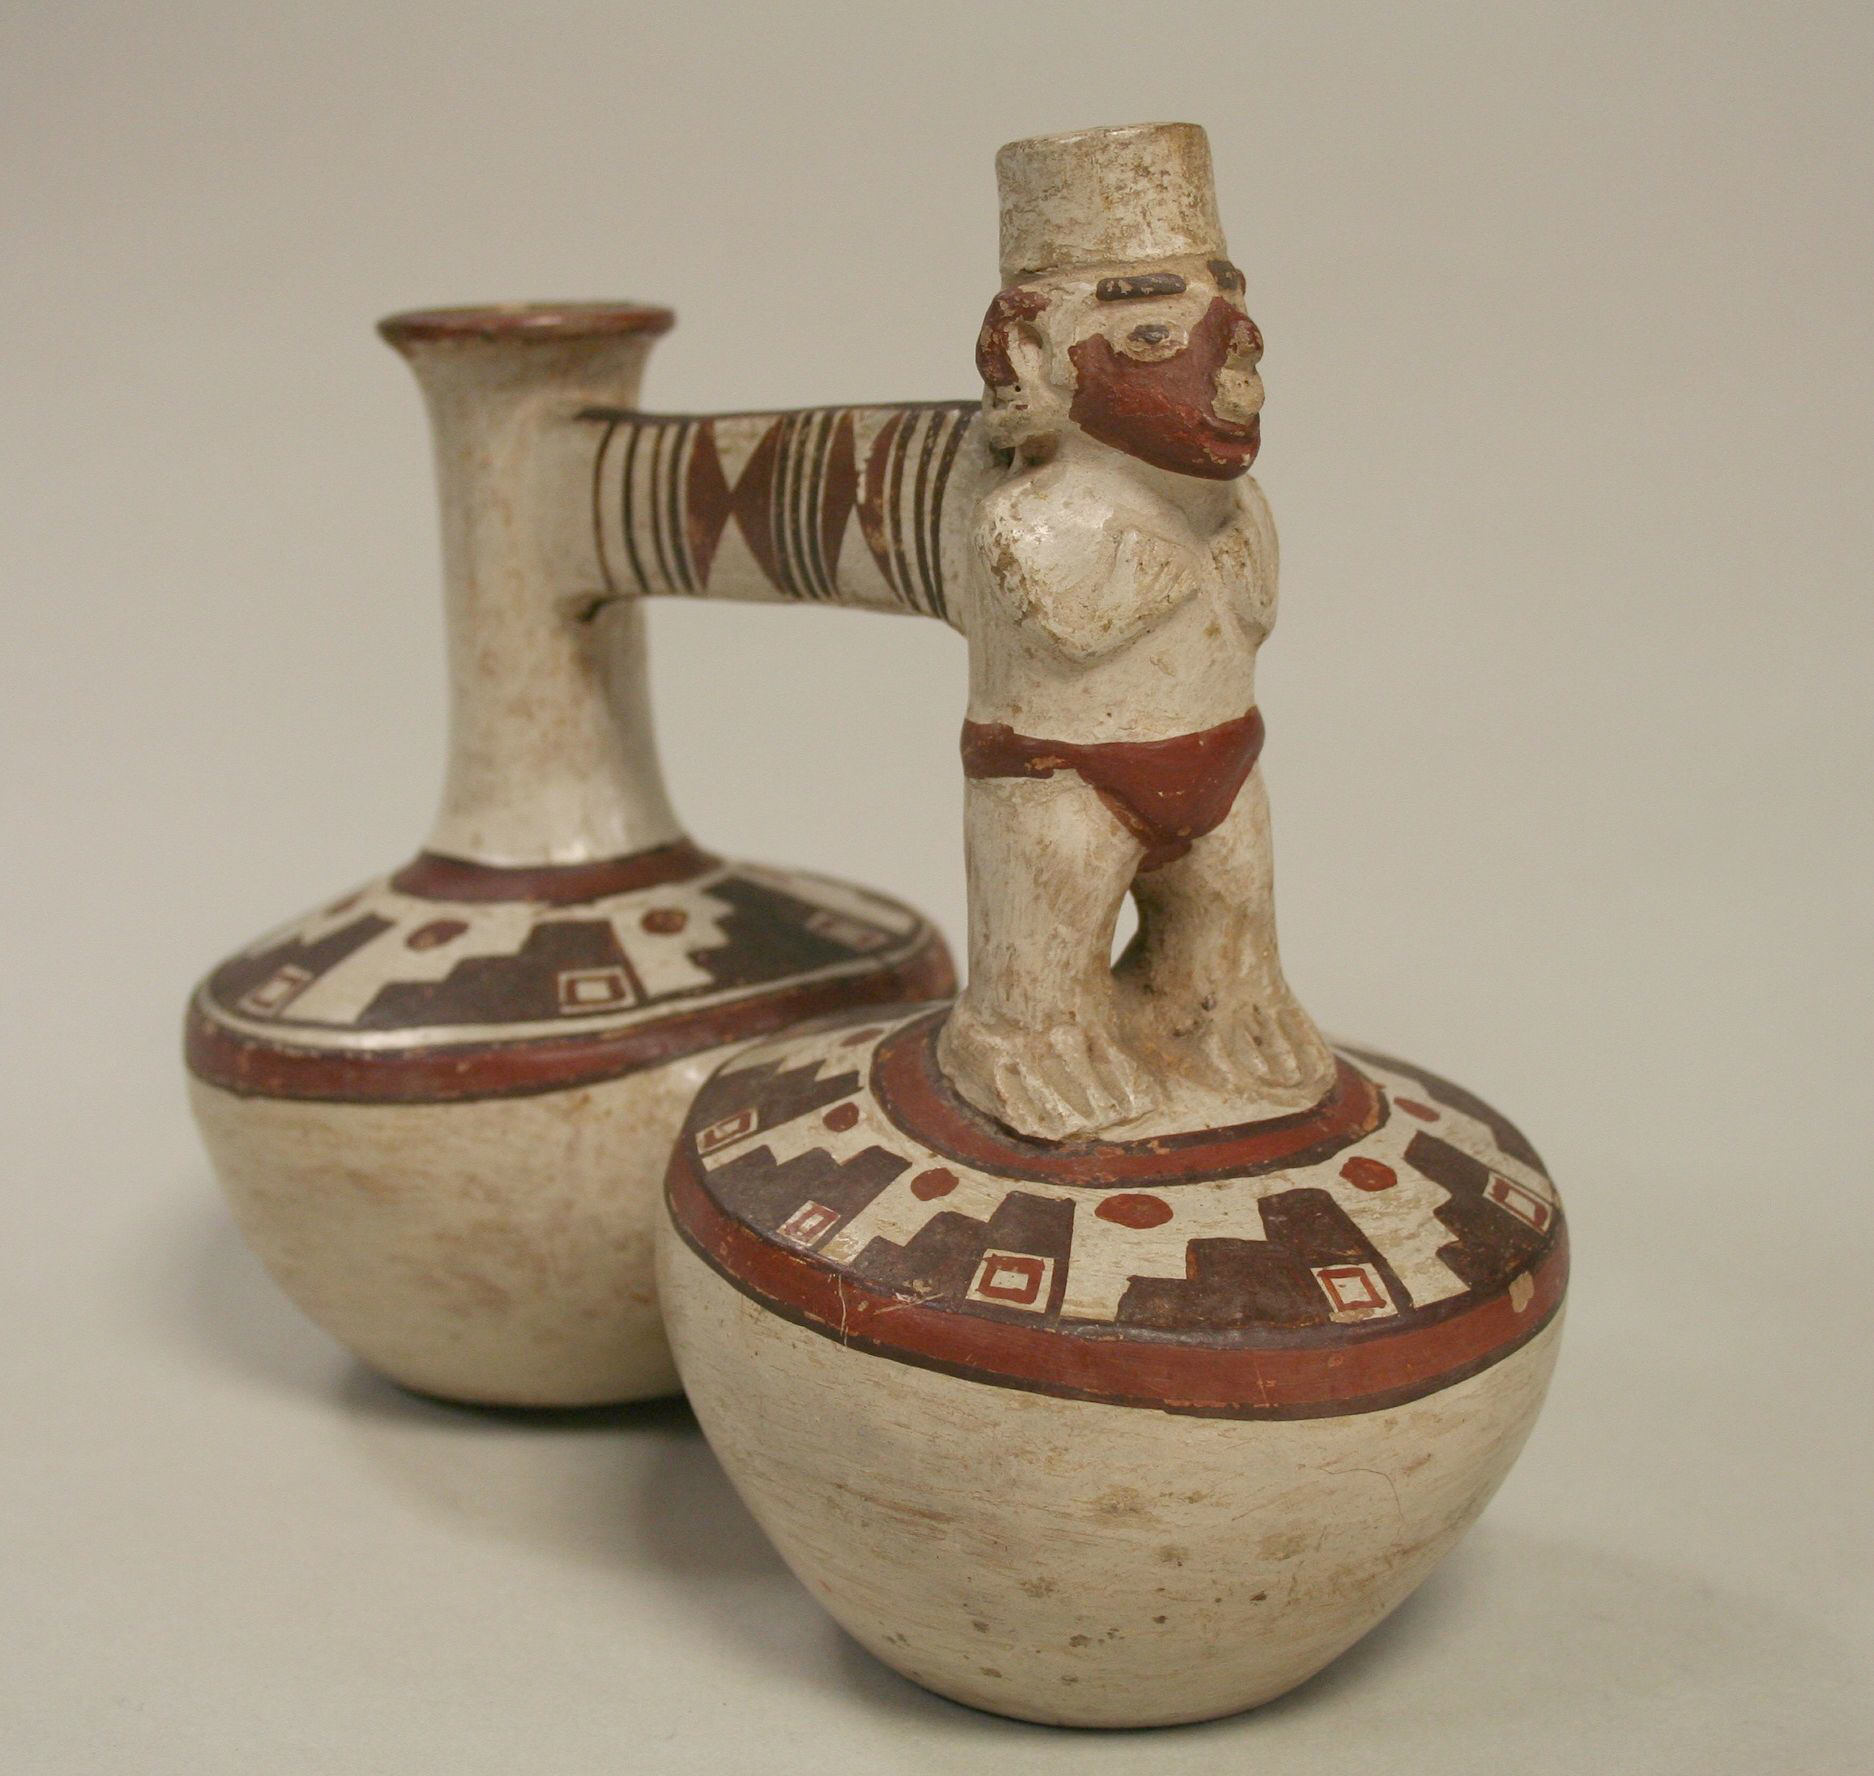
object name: bottle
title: Double Chambered Bottle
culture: inca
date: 1301-1500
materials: ceramic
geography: peru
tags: human figures